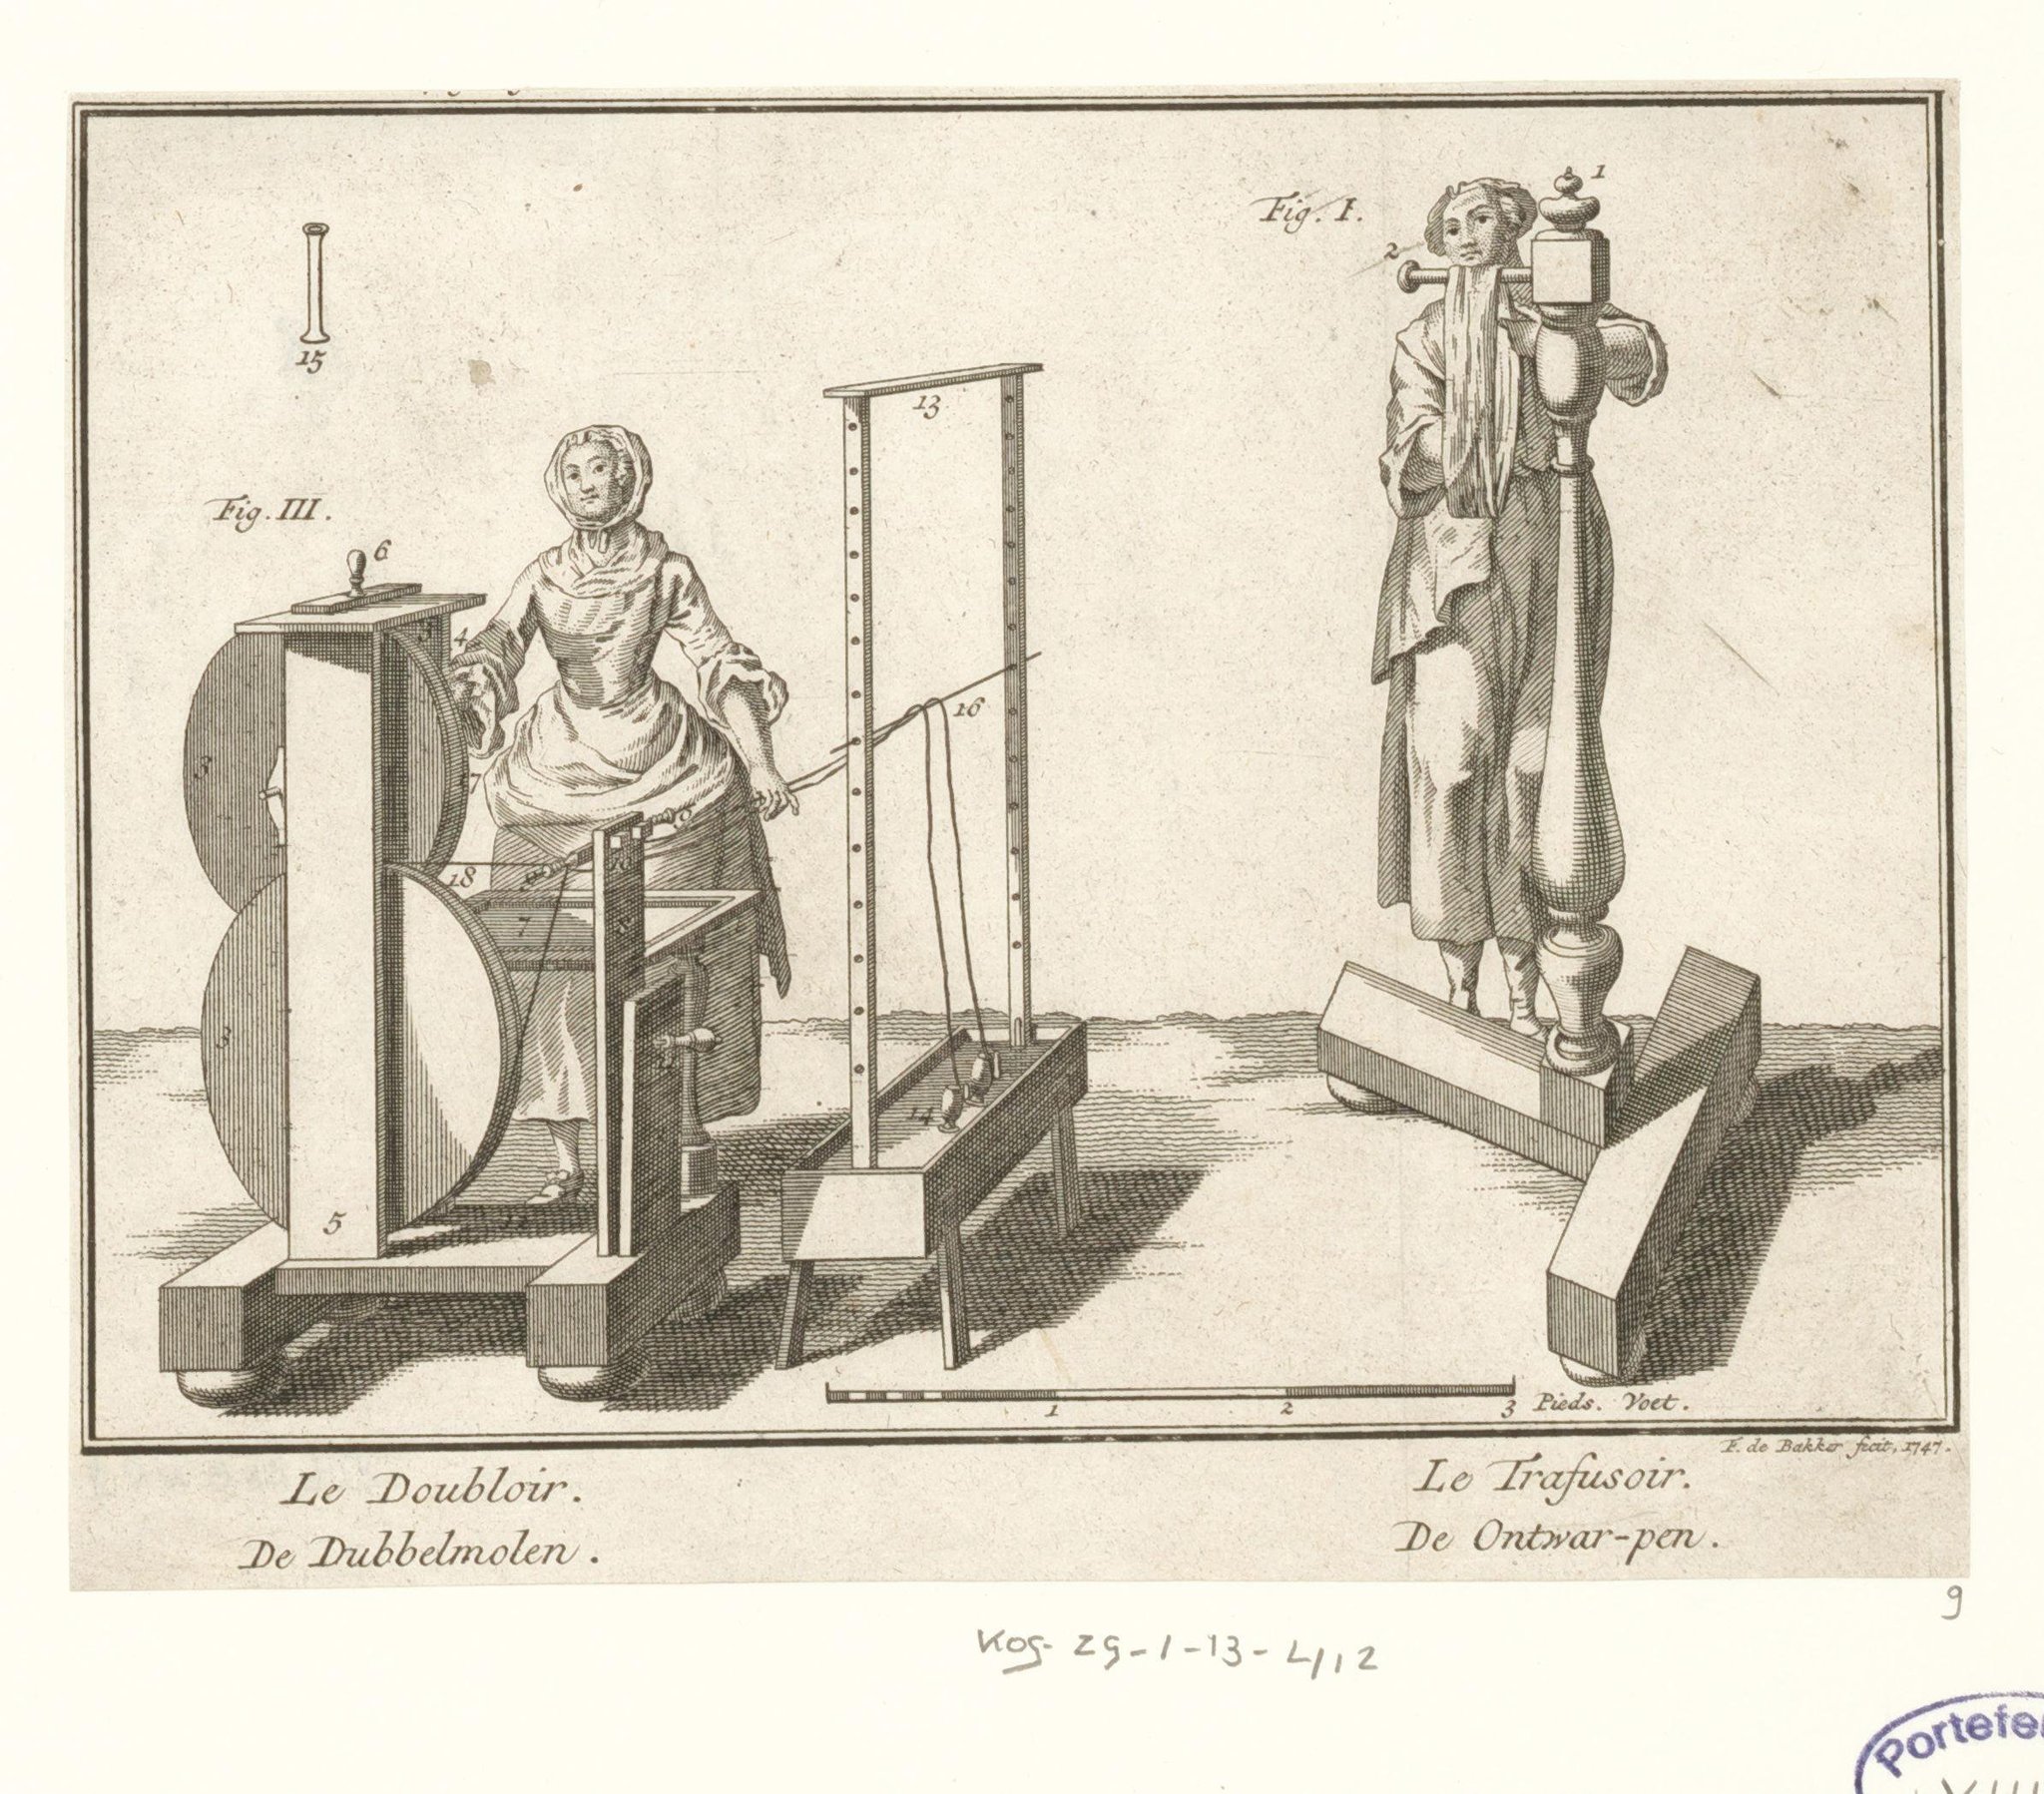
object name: print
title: Le Doubloir / De Dubbelmolen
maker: frans de bakker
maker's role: print maker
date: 1747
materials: paper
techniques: engraving, etching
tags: machines; parts of machines; tools and appliances, textile industry and clothing industry, textile fabric, cloth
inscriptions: stamp, collector's mark: Lugt 1641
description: Vier voorstellingen van de klandermolen en de bediening. In de kalanderij of klandermolen werden geweven stoffen, papier en leer glad gemaakt. Onderaan een schaalmeter. Onderwerpsrubrieken binnen de Atlas Zeden en Gewoonten: Handel, Nijverheid en verkeer, Beroep en bedrijf, Mannelijk, Wevers.